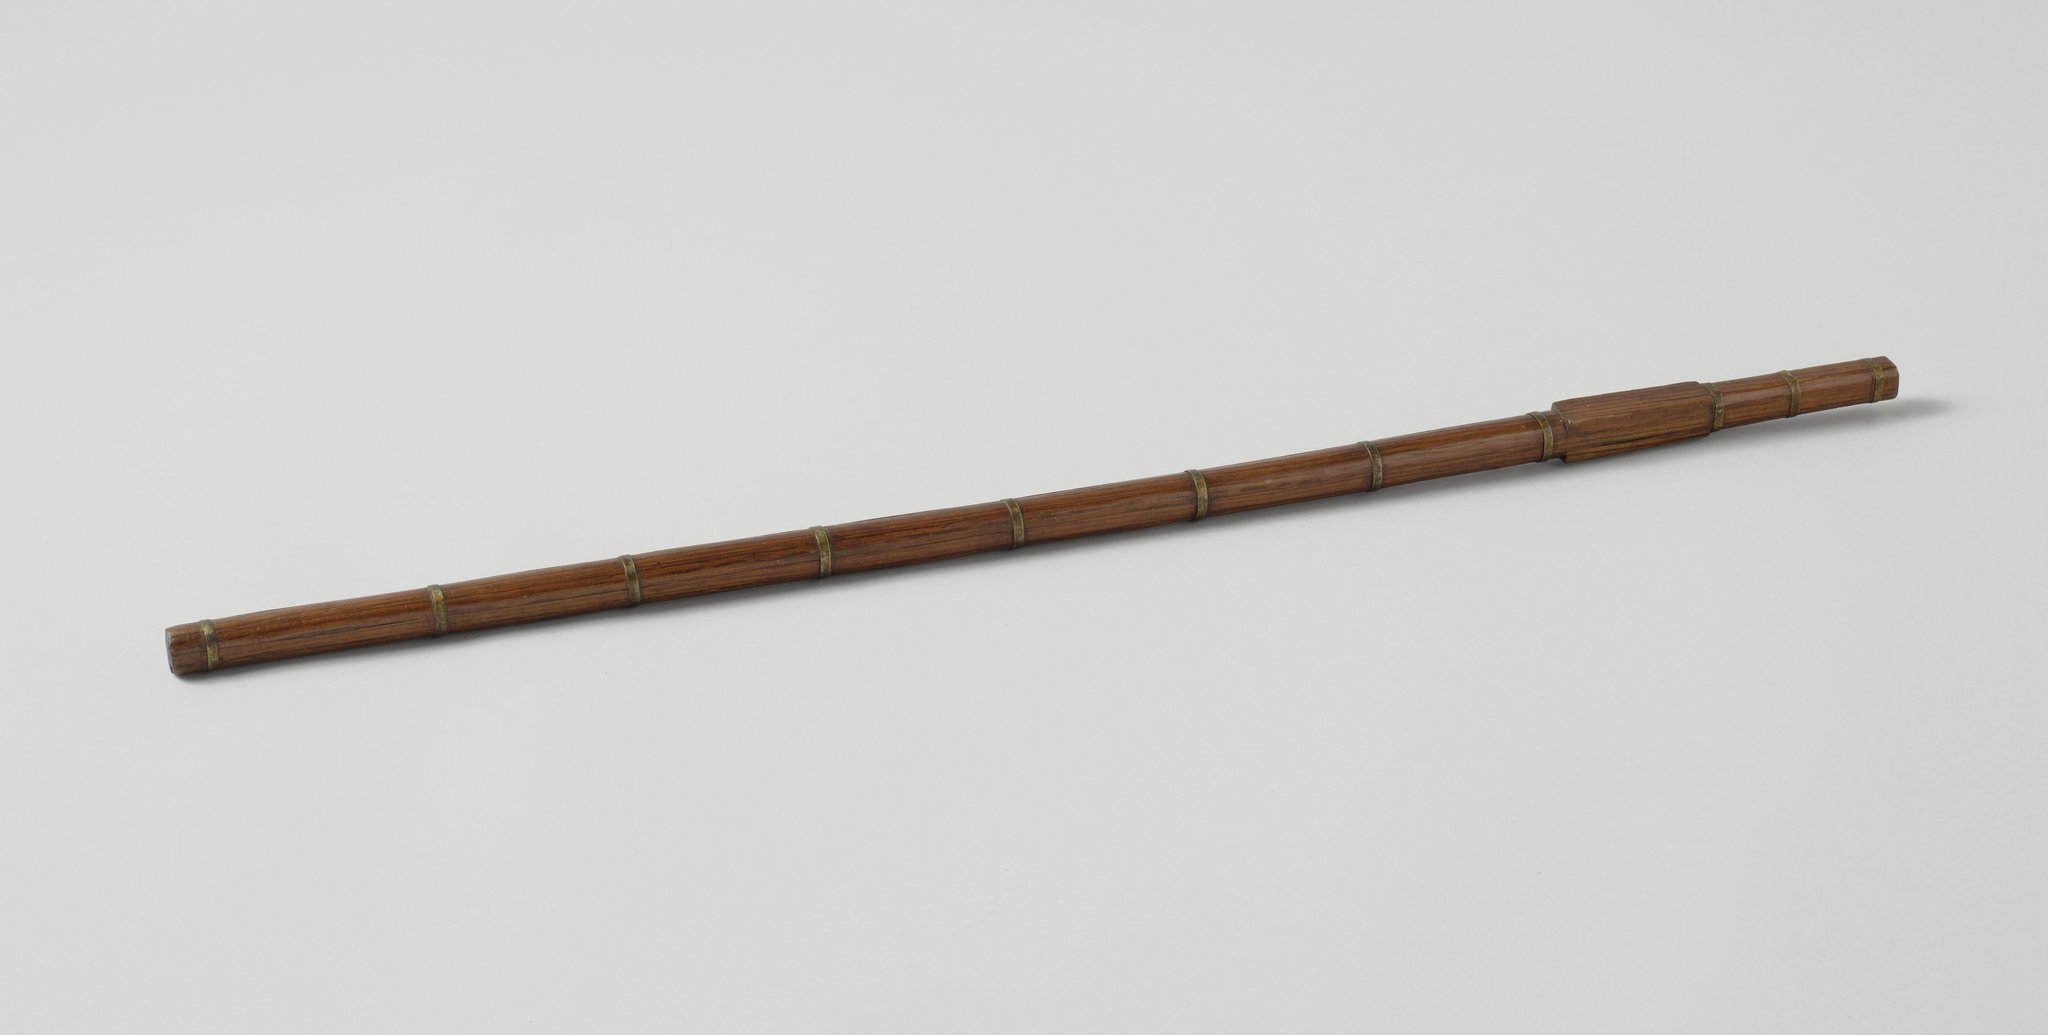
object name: demonstration model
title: Model of a Made Mast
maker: Anonymous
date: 1780-1840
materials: brass, wood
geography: netherlands